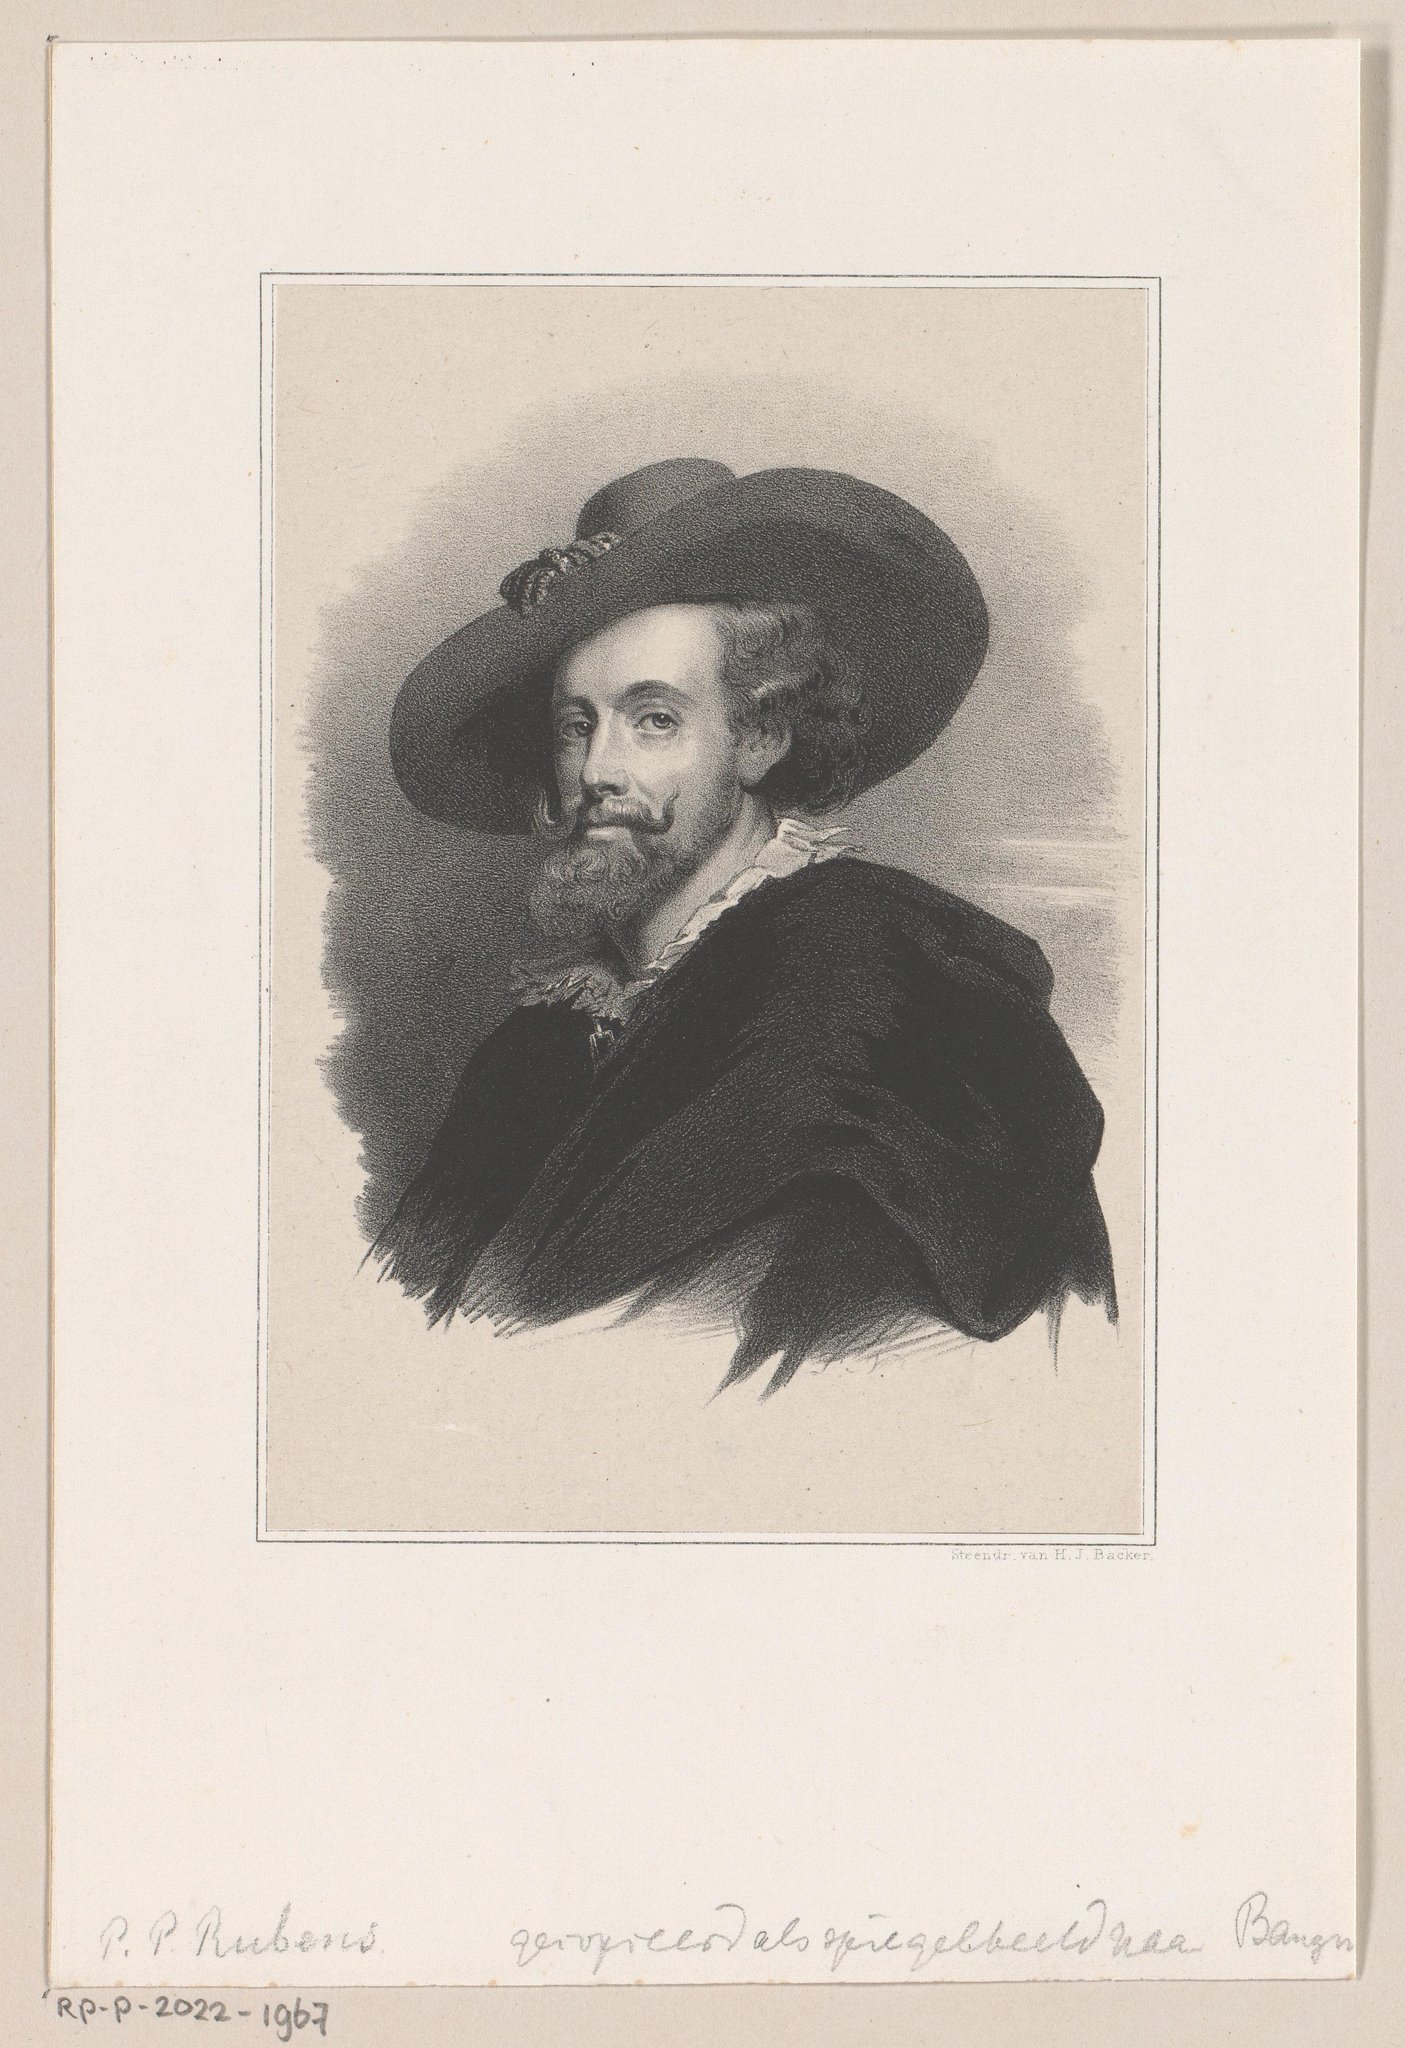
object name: print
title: Portret van Peter Paul Rubens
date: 1822-1845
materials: paper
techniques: lithograph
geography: dordrecht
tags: antwerp, painter, print maker, draughtsman, peter paul rubens, historical persons, portrait, self-portrait of artist